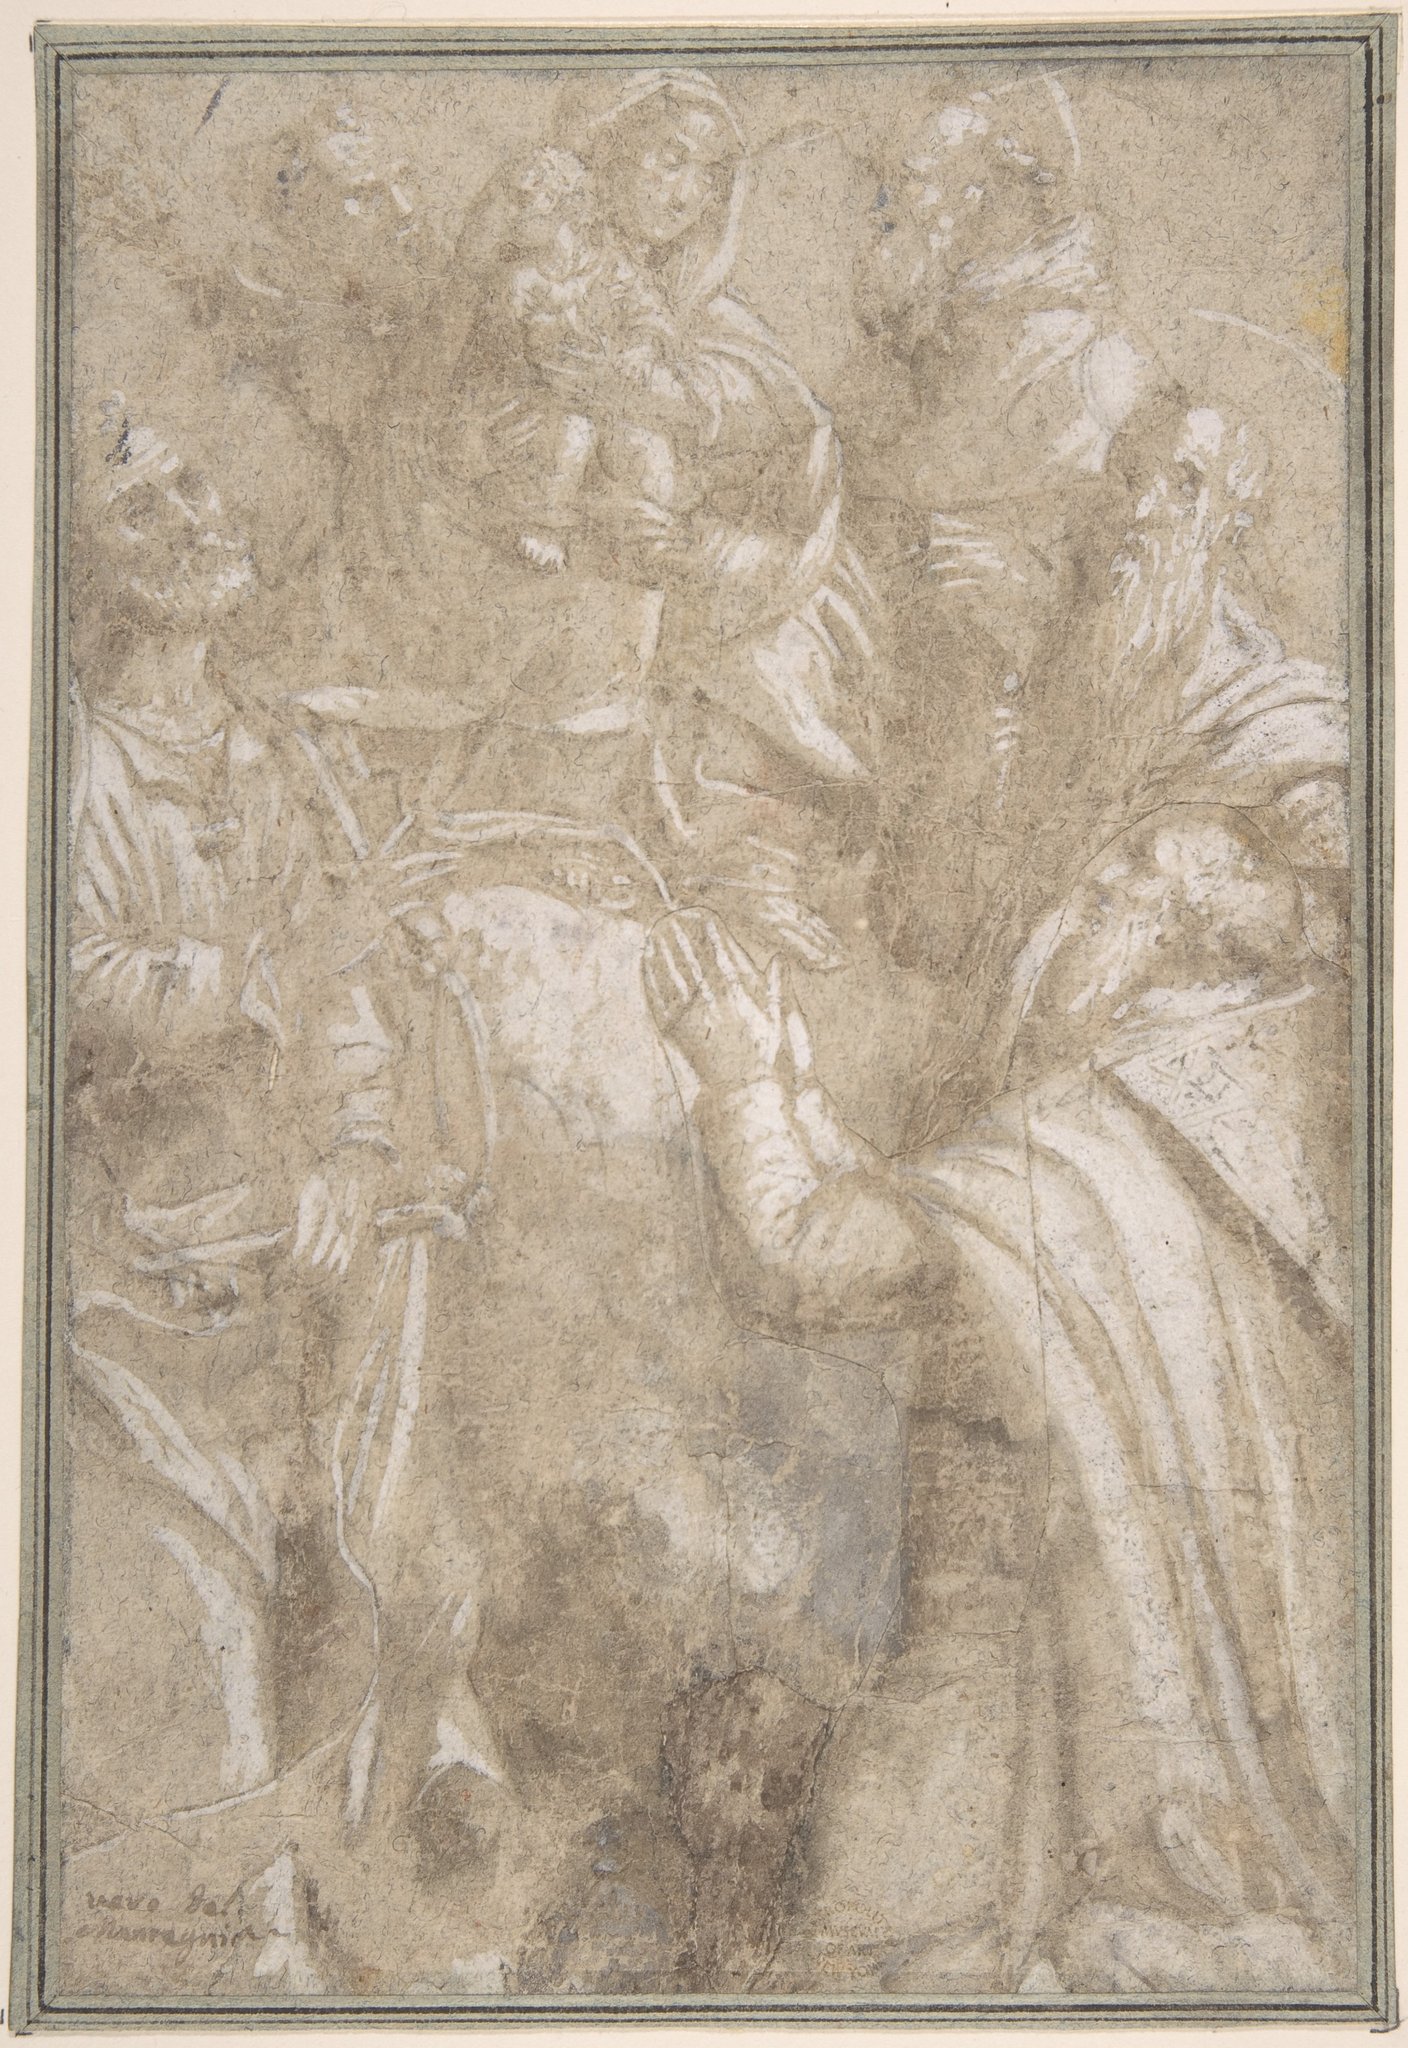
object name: drawing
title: Adoration of the Madonna and Child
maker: anonymous, italian, 15th to 16th century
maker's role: artist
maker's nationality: italian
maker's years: 1400-1700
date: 1400-1600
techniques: brush, heightening, wash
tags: men,madonna and child